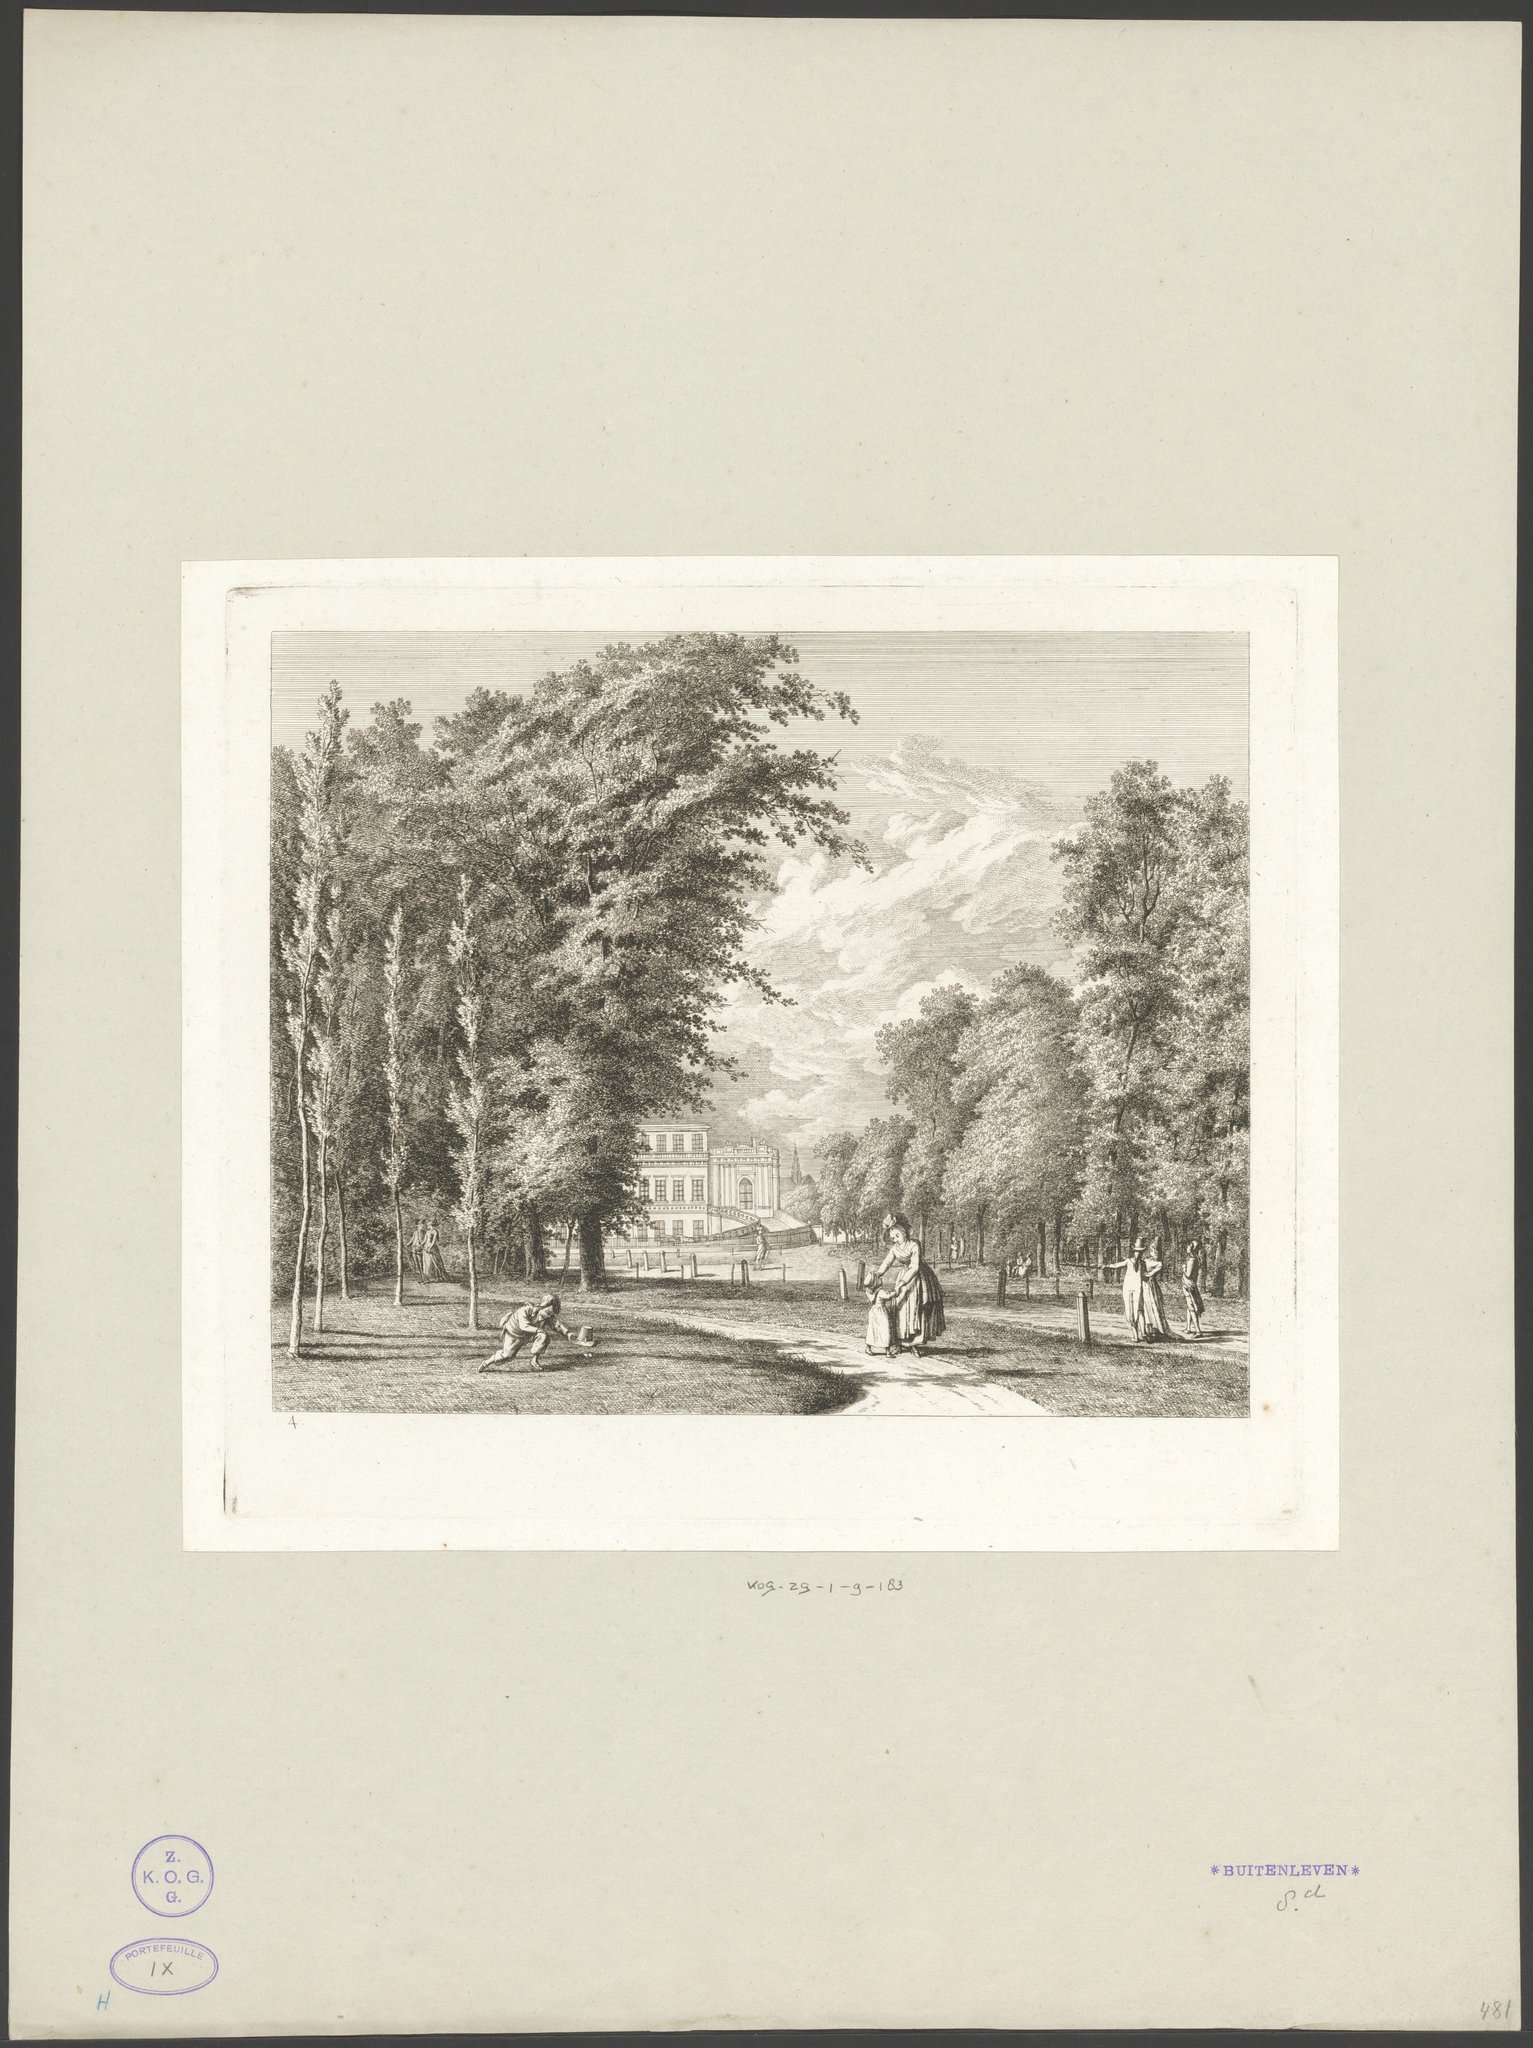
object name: print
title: Gezicht op een buitenplaats bij Haarlem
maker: Anonymous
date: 1750-1849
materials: paper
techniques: etching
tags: villa, hunting butterflies, haarlem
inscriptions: stamp, collector's mark: Lugt 1641, stamp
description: Gezicht op een buitenplaats bij Haarlem. Op de voorgrond probeert een jongen een vlinder te vangen met zijn hoed en een vrouw danst met een meisje. Linksonder: 4. Onderwerpsrubrieken binnen de Atlas Zeden en Gewoonten: Handel, nijverheid en verkeer, Buitenleven.